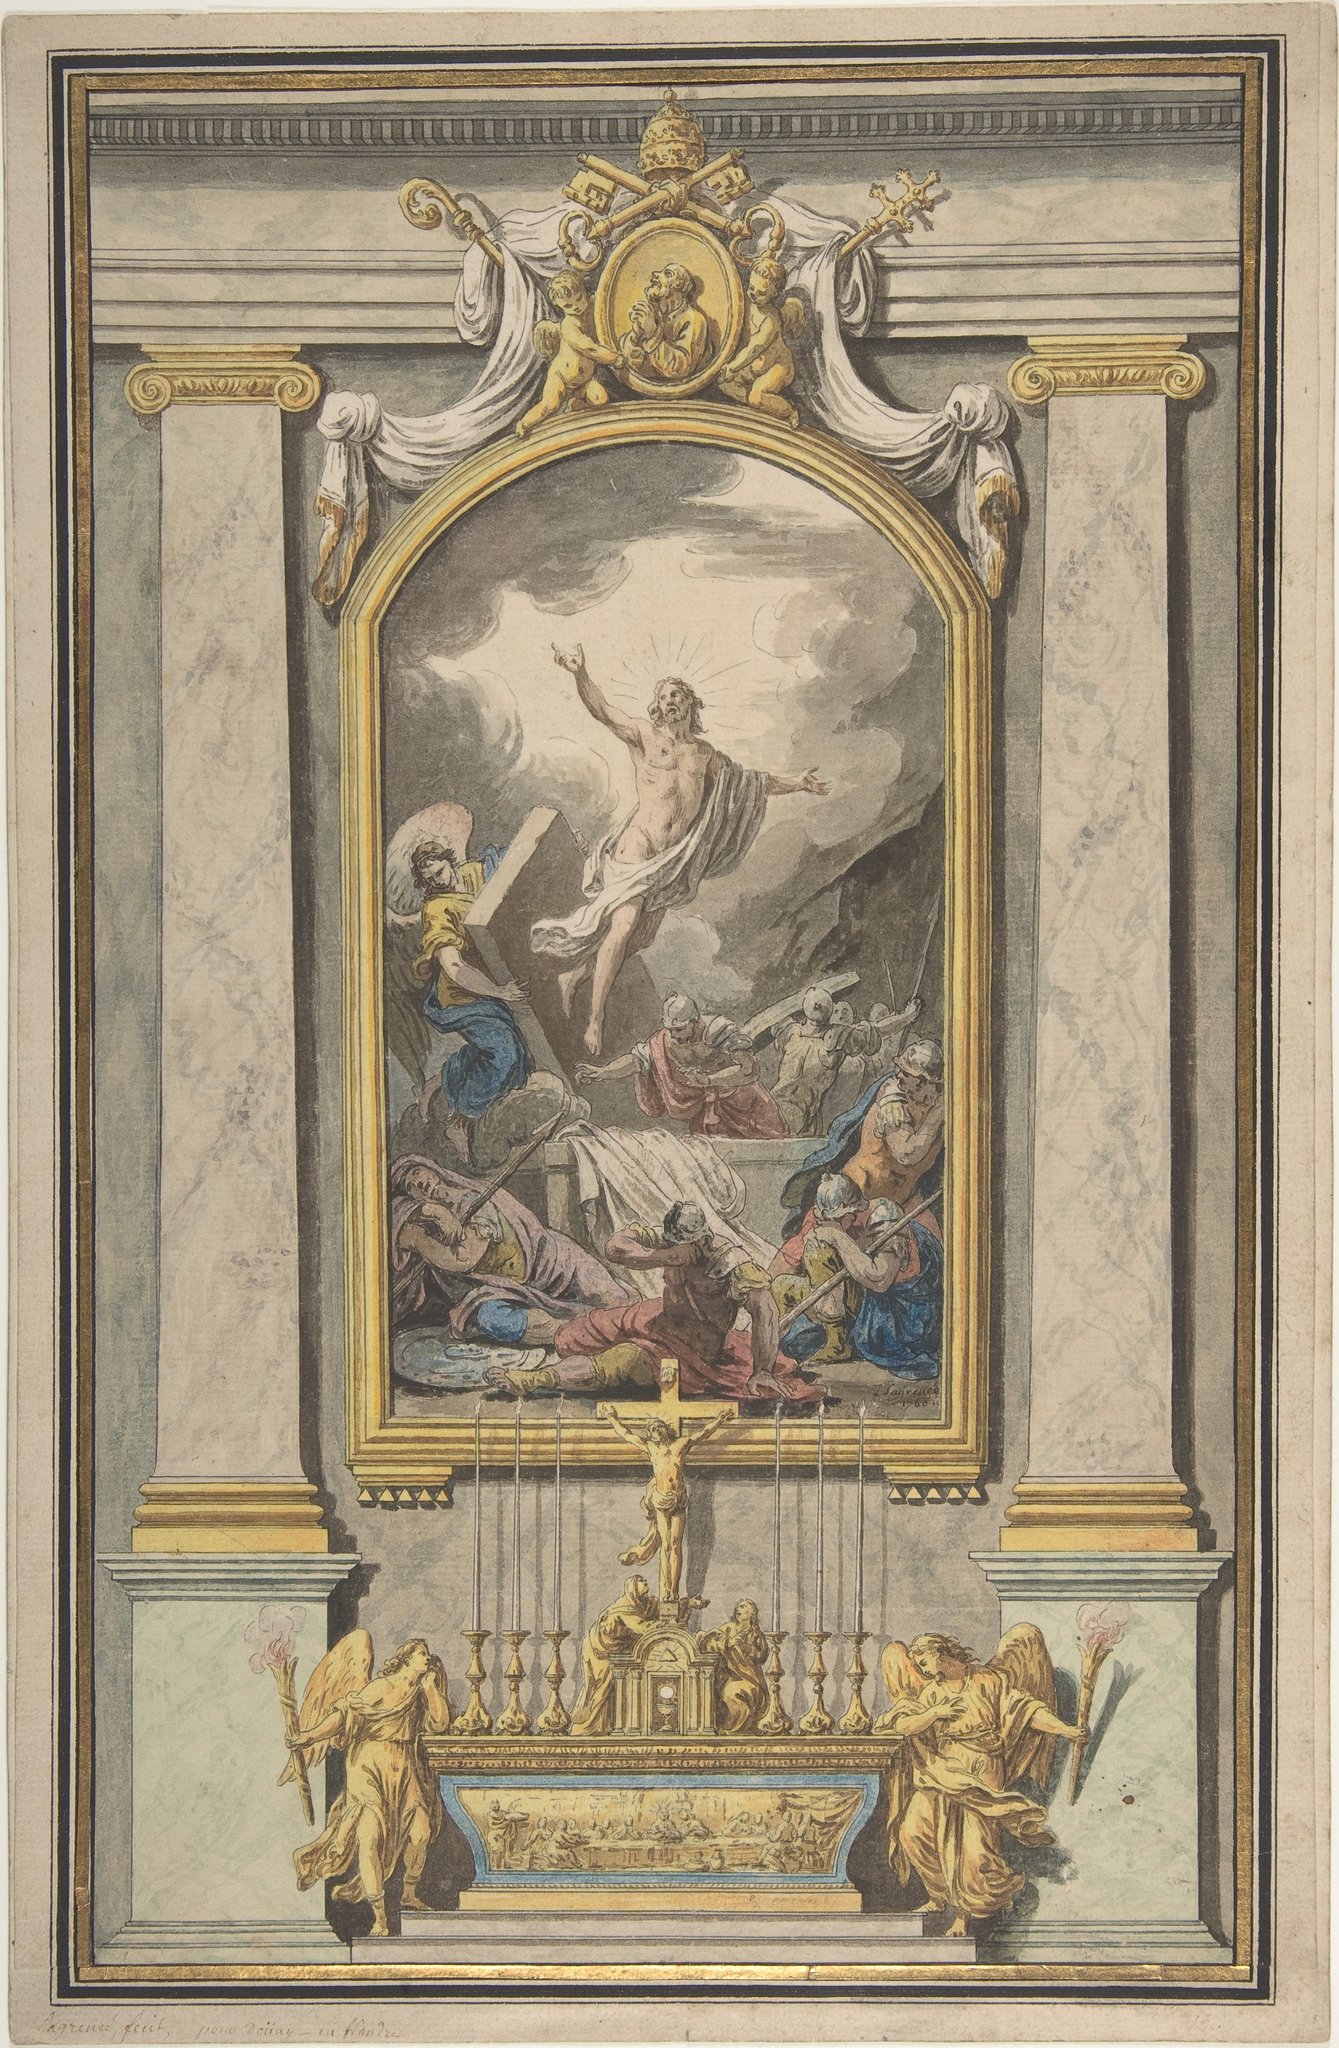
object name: drawing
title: The Resurrection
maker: louis lagrenée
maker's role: artist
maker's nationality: french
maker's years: 1725-1805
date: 1760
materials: graphite, ink, watercolor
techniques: pen, wash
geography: france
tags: soldiers,angels,christ